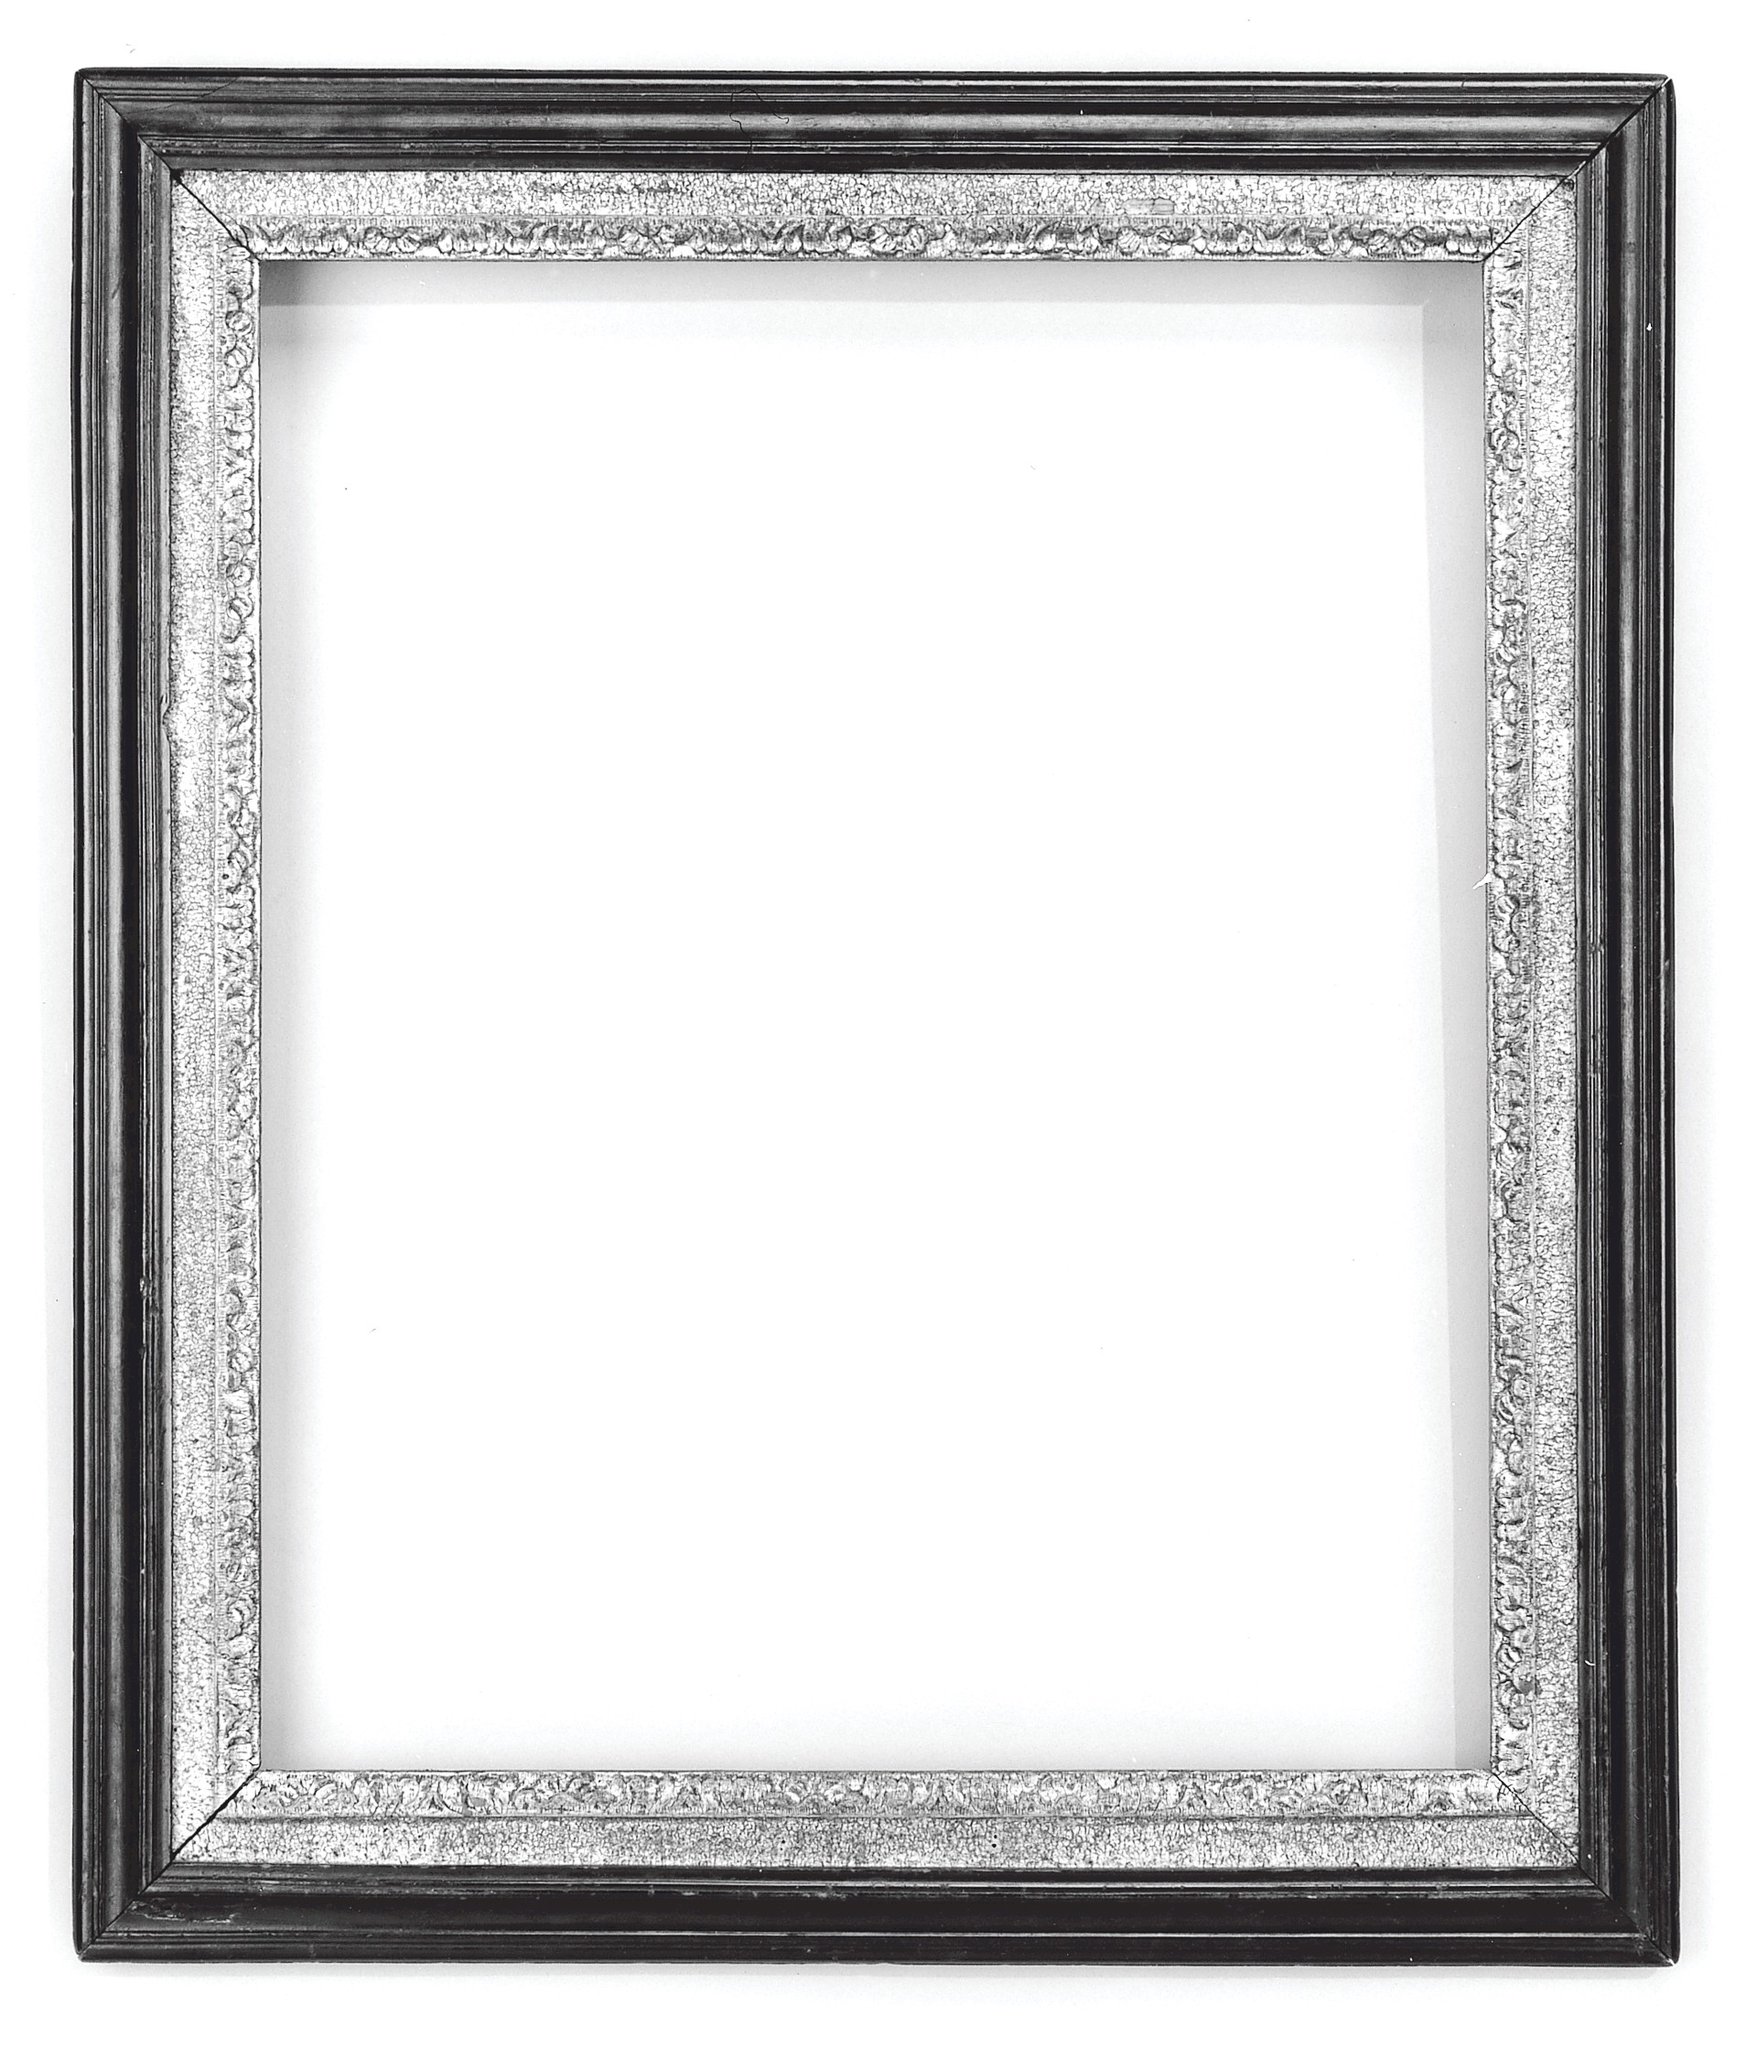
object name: frame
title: Reverse Hogarth molding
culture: british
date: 1740-1750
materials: feather, wood